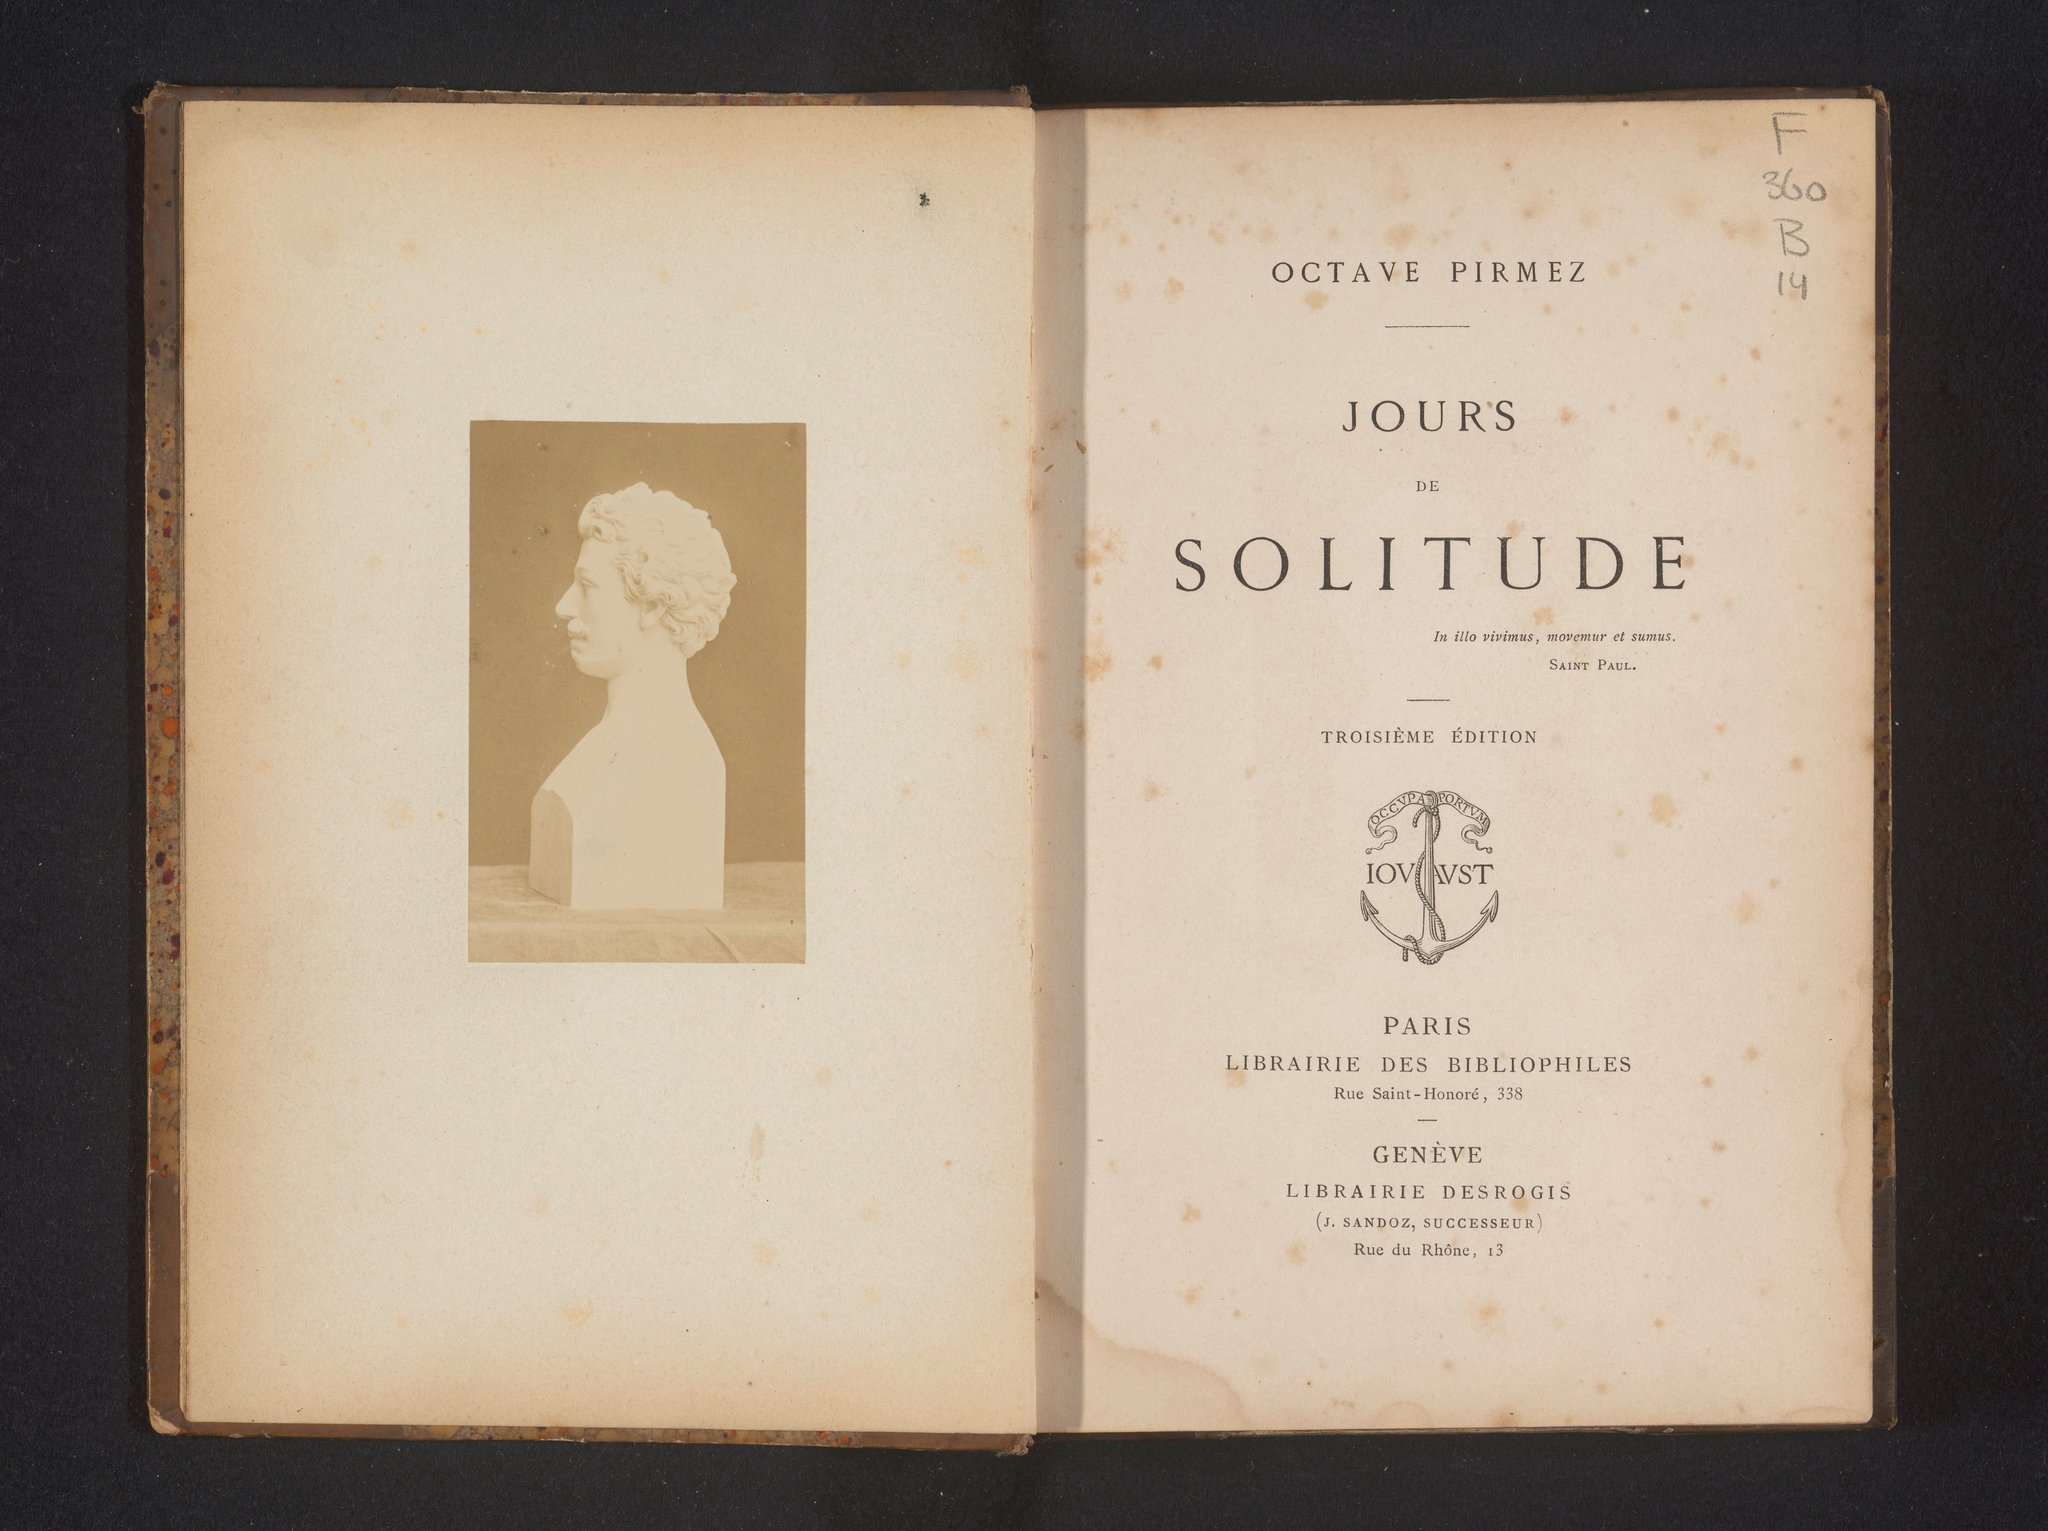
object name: book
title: Jours de solitude / Octave Pirmez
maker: octave pirmez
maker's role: schrijver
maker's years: 1832-1883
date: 1877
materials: cardboard, leather, paper, photographic support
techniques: albumen print, marbled paper, decorated paper, printing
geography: paris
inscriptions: annotation: ‘1877 1 afb en fsp 950’